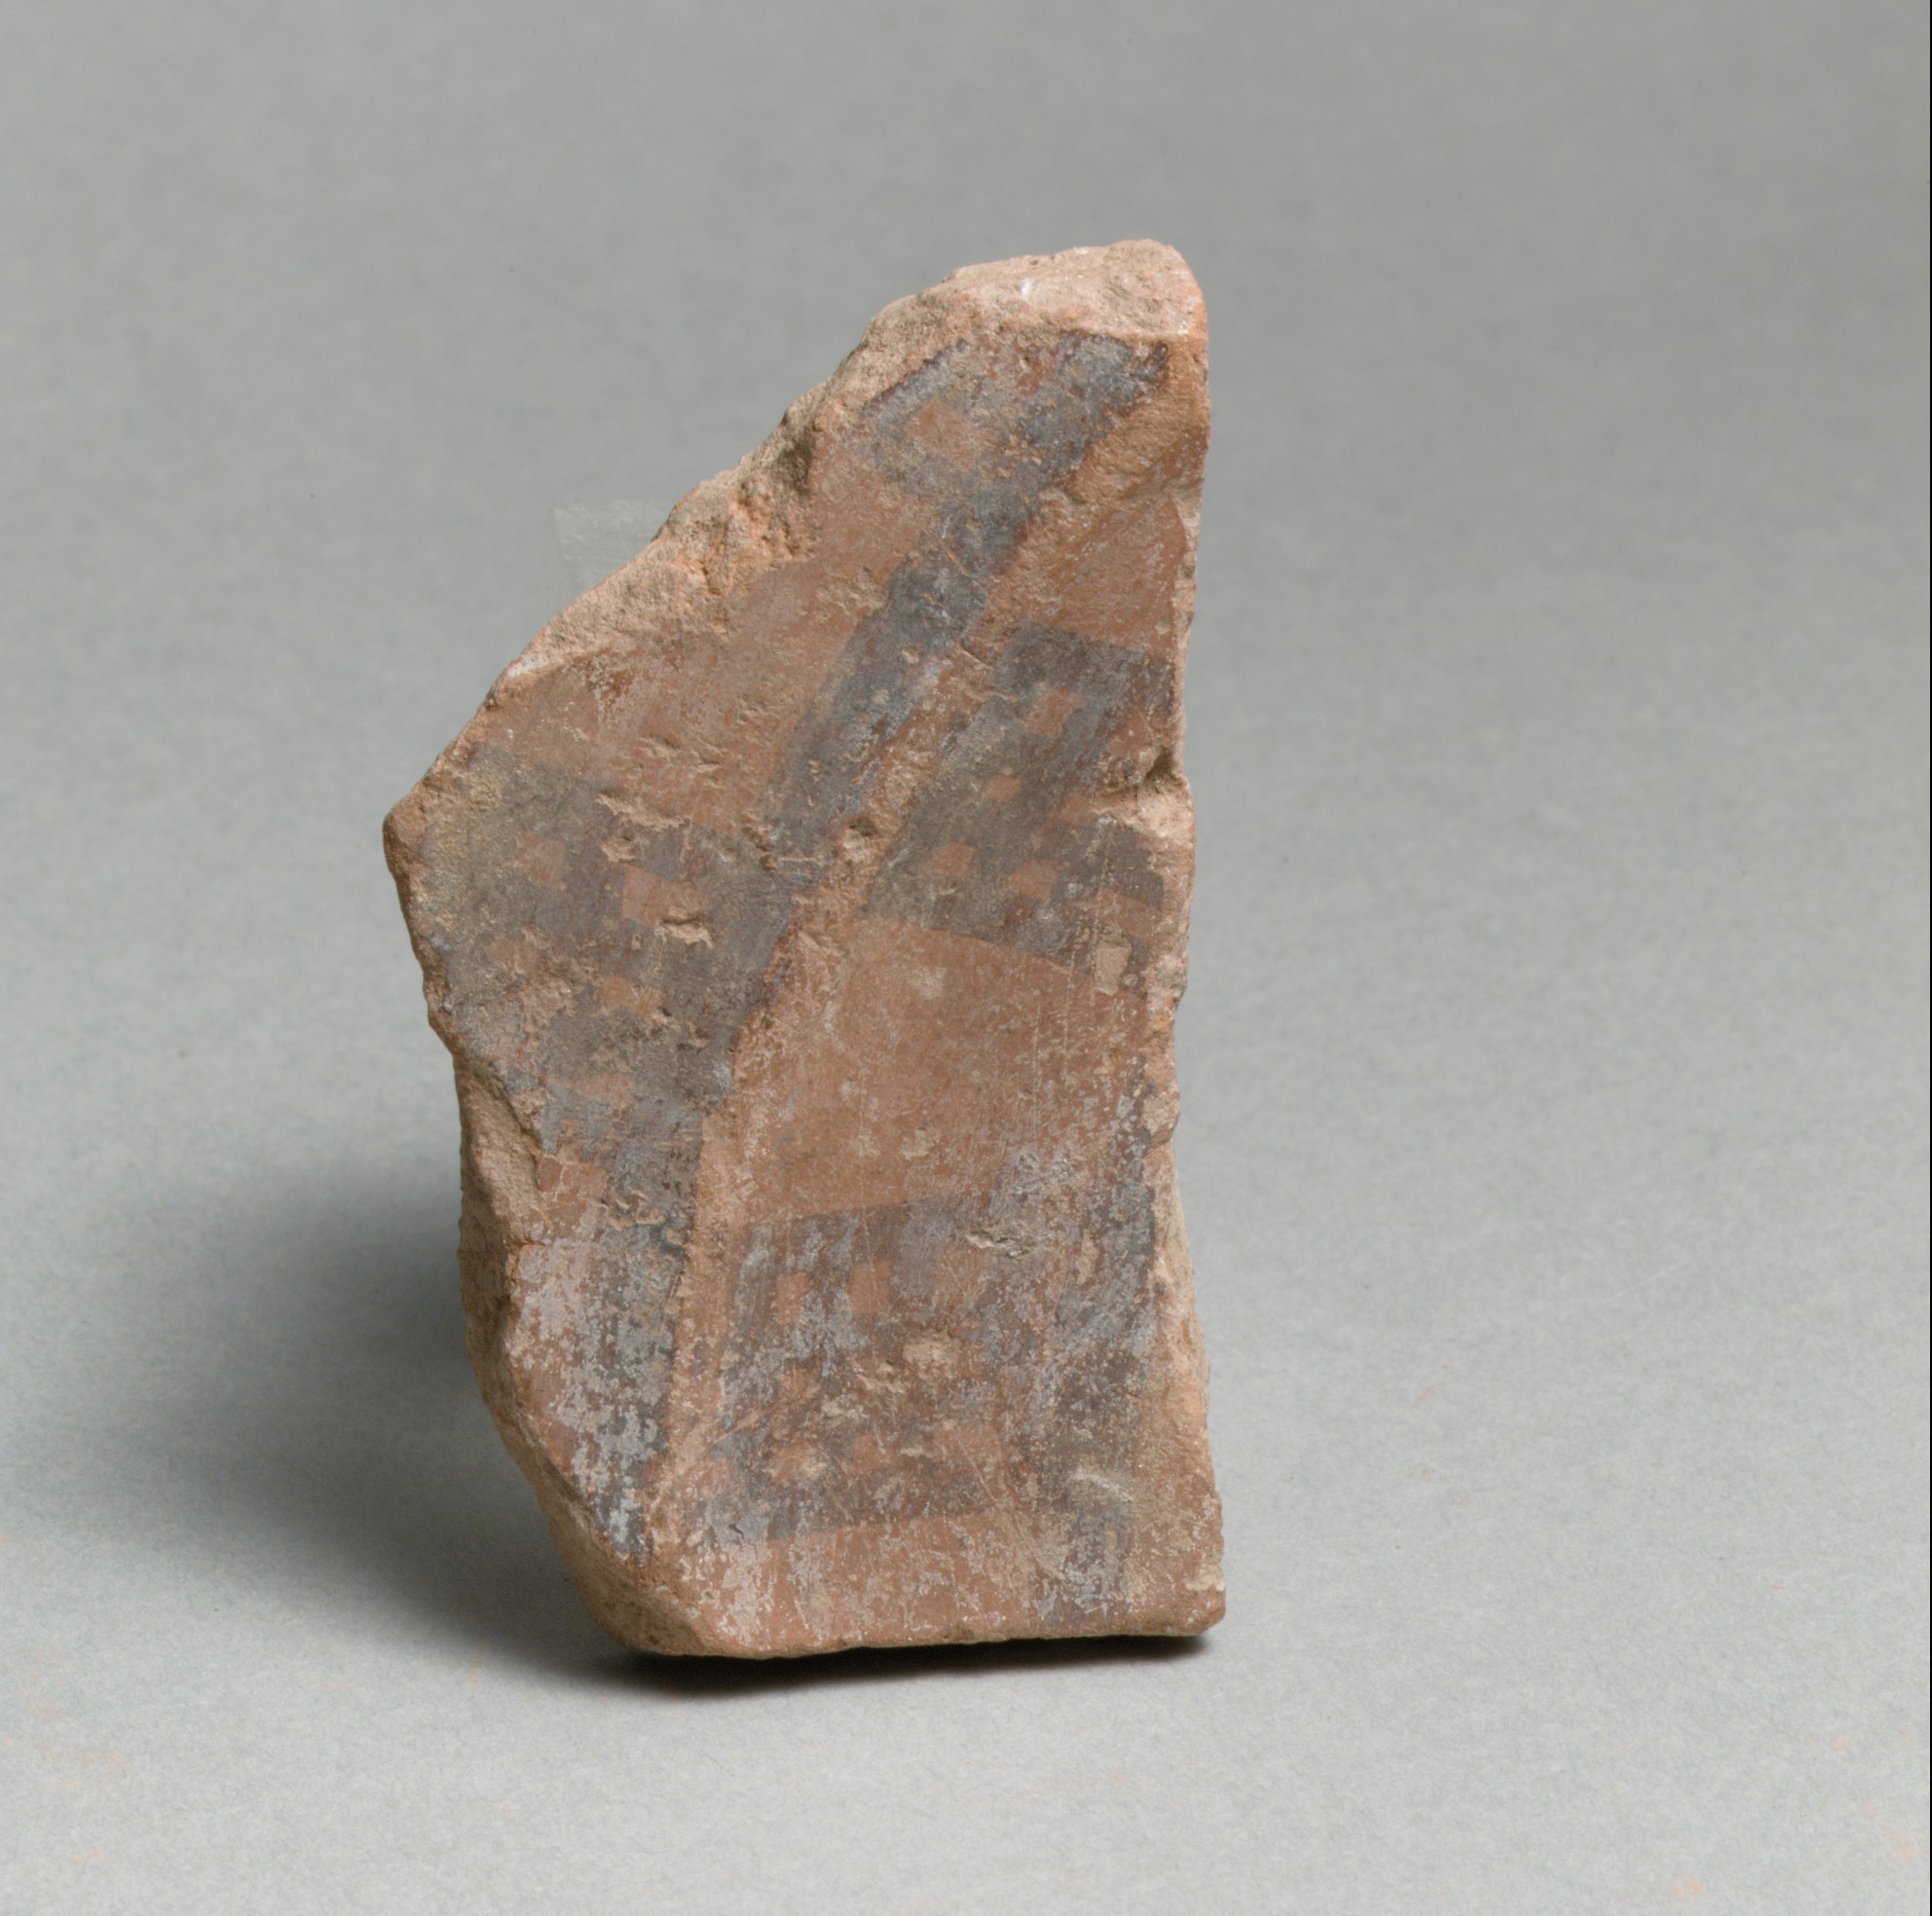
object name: vase fragment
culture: greek or lydian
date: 1050-700 BCE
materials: terracotta